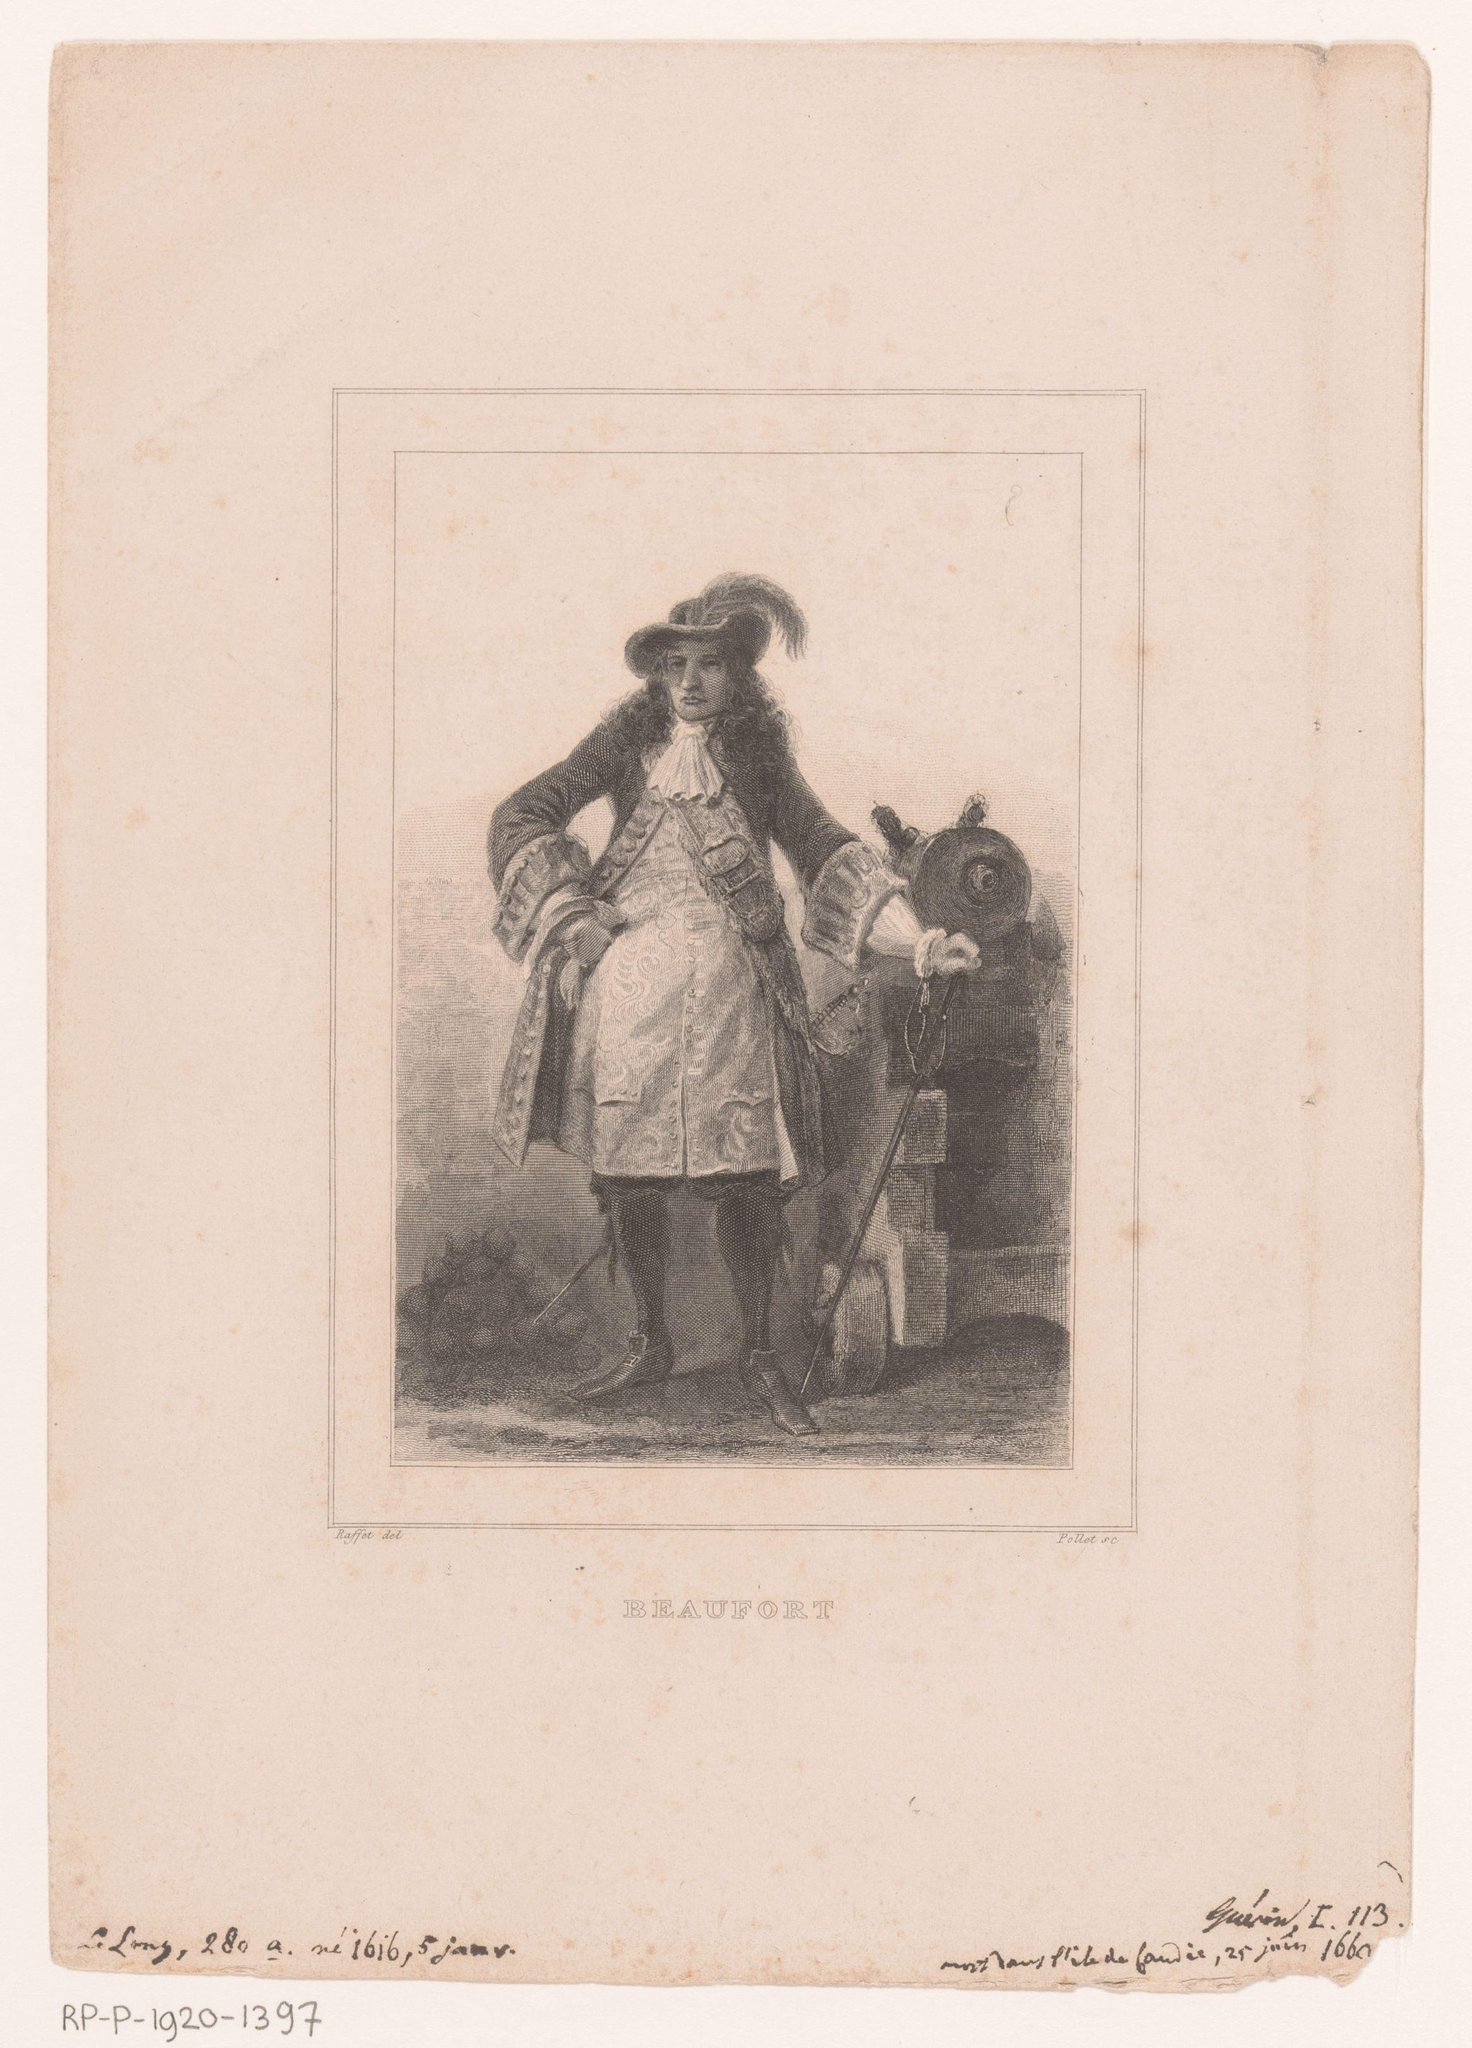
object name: book illustration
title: Portret van François de Vendôme van Beaufort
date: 1835-1837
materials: paper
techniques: etching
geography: paris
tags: historical persons, ranks in the navy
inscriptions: collector's mark: Lugt 2228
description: Prent uit: Sue, Eugène. Histoire de la marine française. Parijs: Félix Bonnaire, 1835-1837, 5 delen.